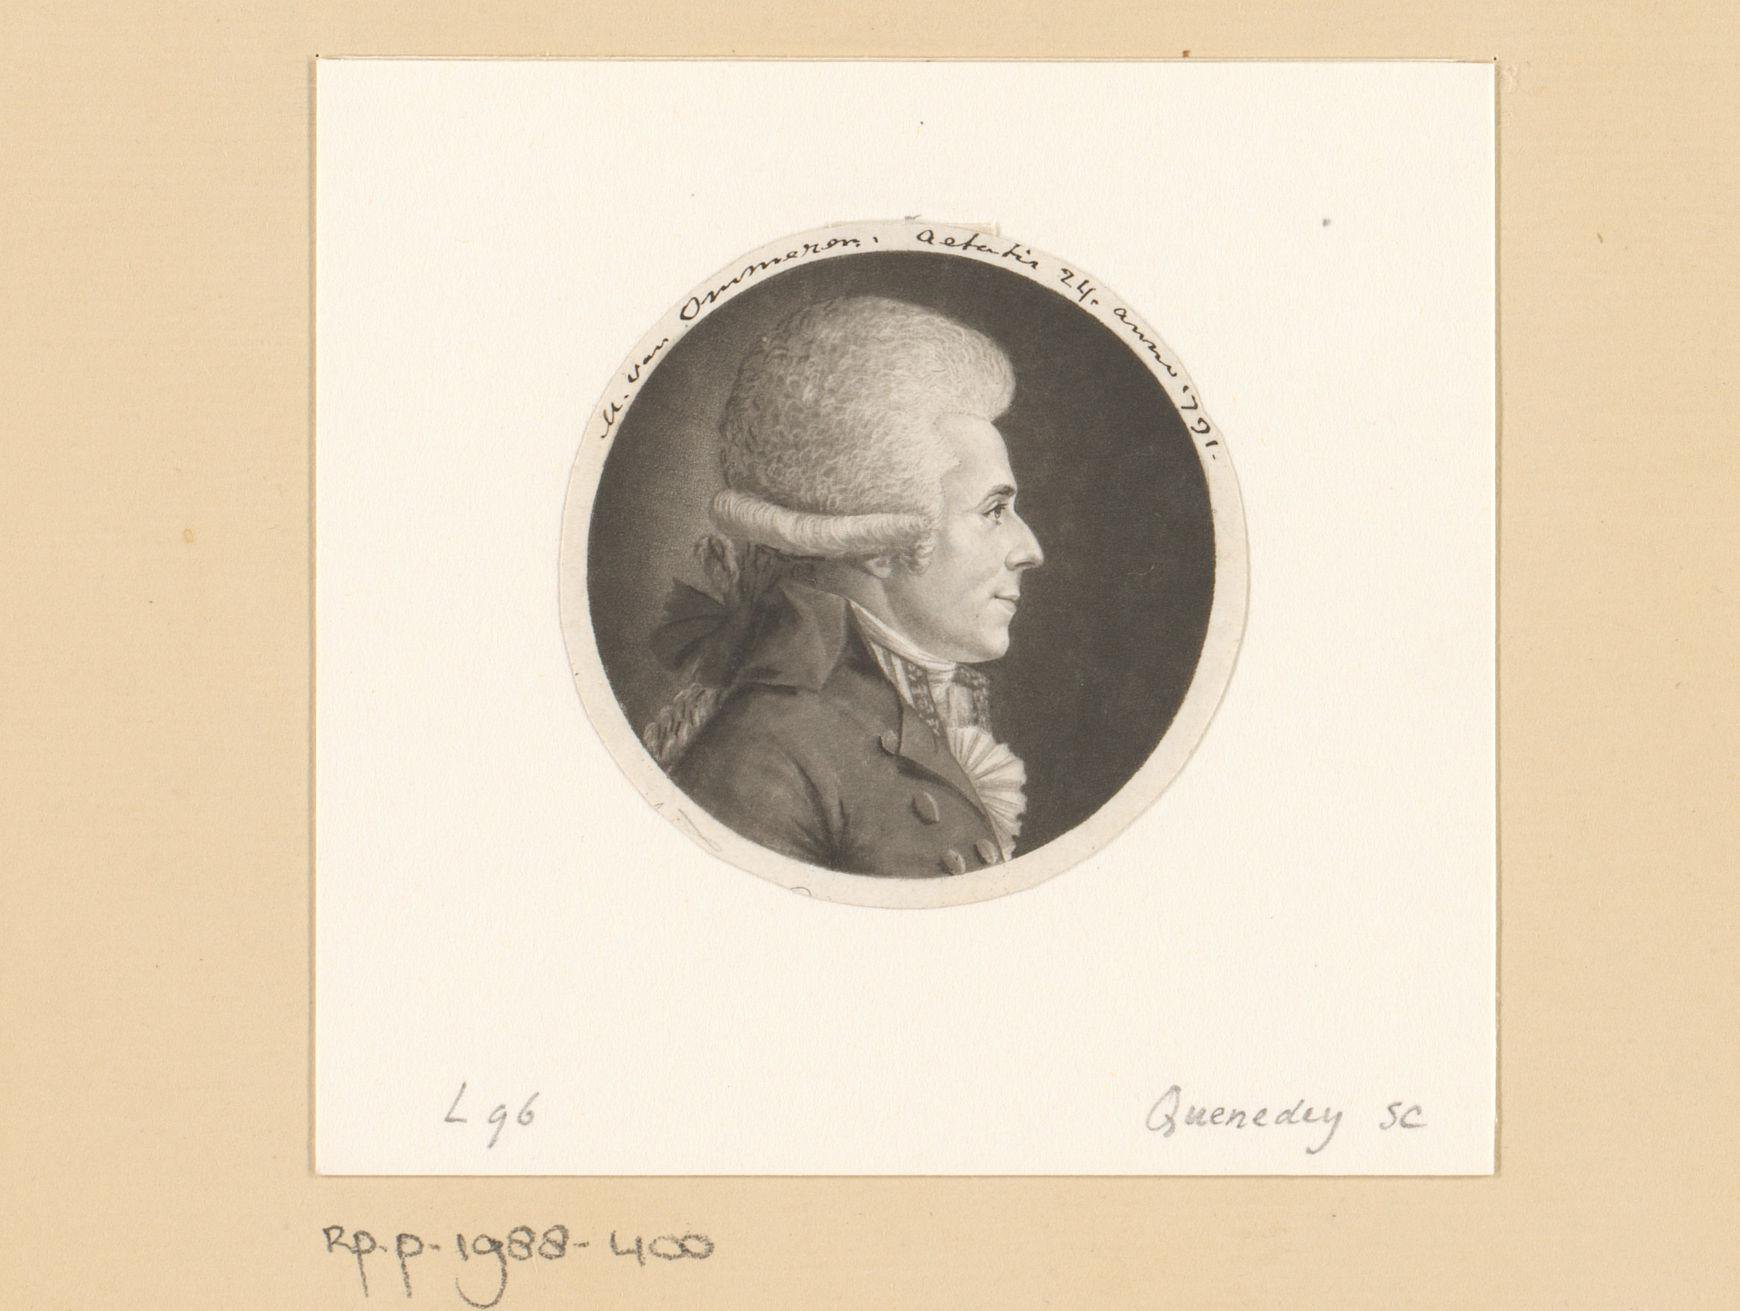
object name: physionotrace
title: Portret van een onbekende man, aangeduid als M. van Ommeren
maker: edme quenedey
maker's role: print maker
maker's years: 1756-1830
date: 1791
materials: paper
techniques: aquatint, etching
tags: silhouette-apparatus, 'physionotrace', historical persons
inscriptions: collector's mark: Lugt 2228, annotation: ‘M. van Ommneren. Aetatis 24. Anno 1791.’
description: Mogelijk is dit mr. Martinus Adrianus van Ommeren (1765-1831). Boven de prent staat echter aangegeven dat de afgebeelde persoon op dat moment (1791) 24 jaar oud is. Deze prent heeft nummer L.96 binnen het fonds van Quenedey.